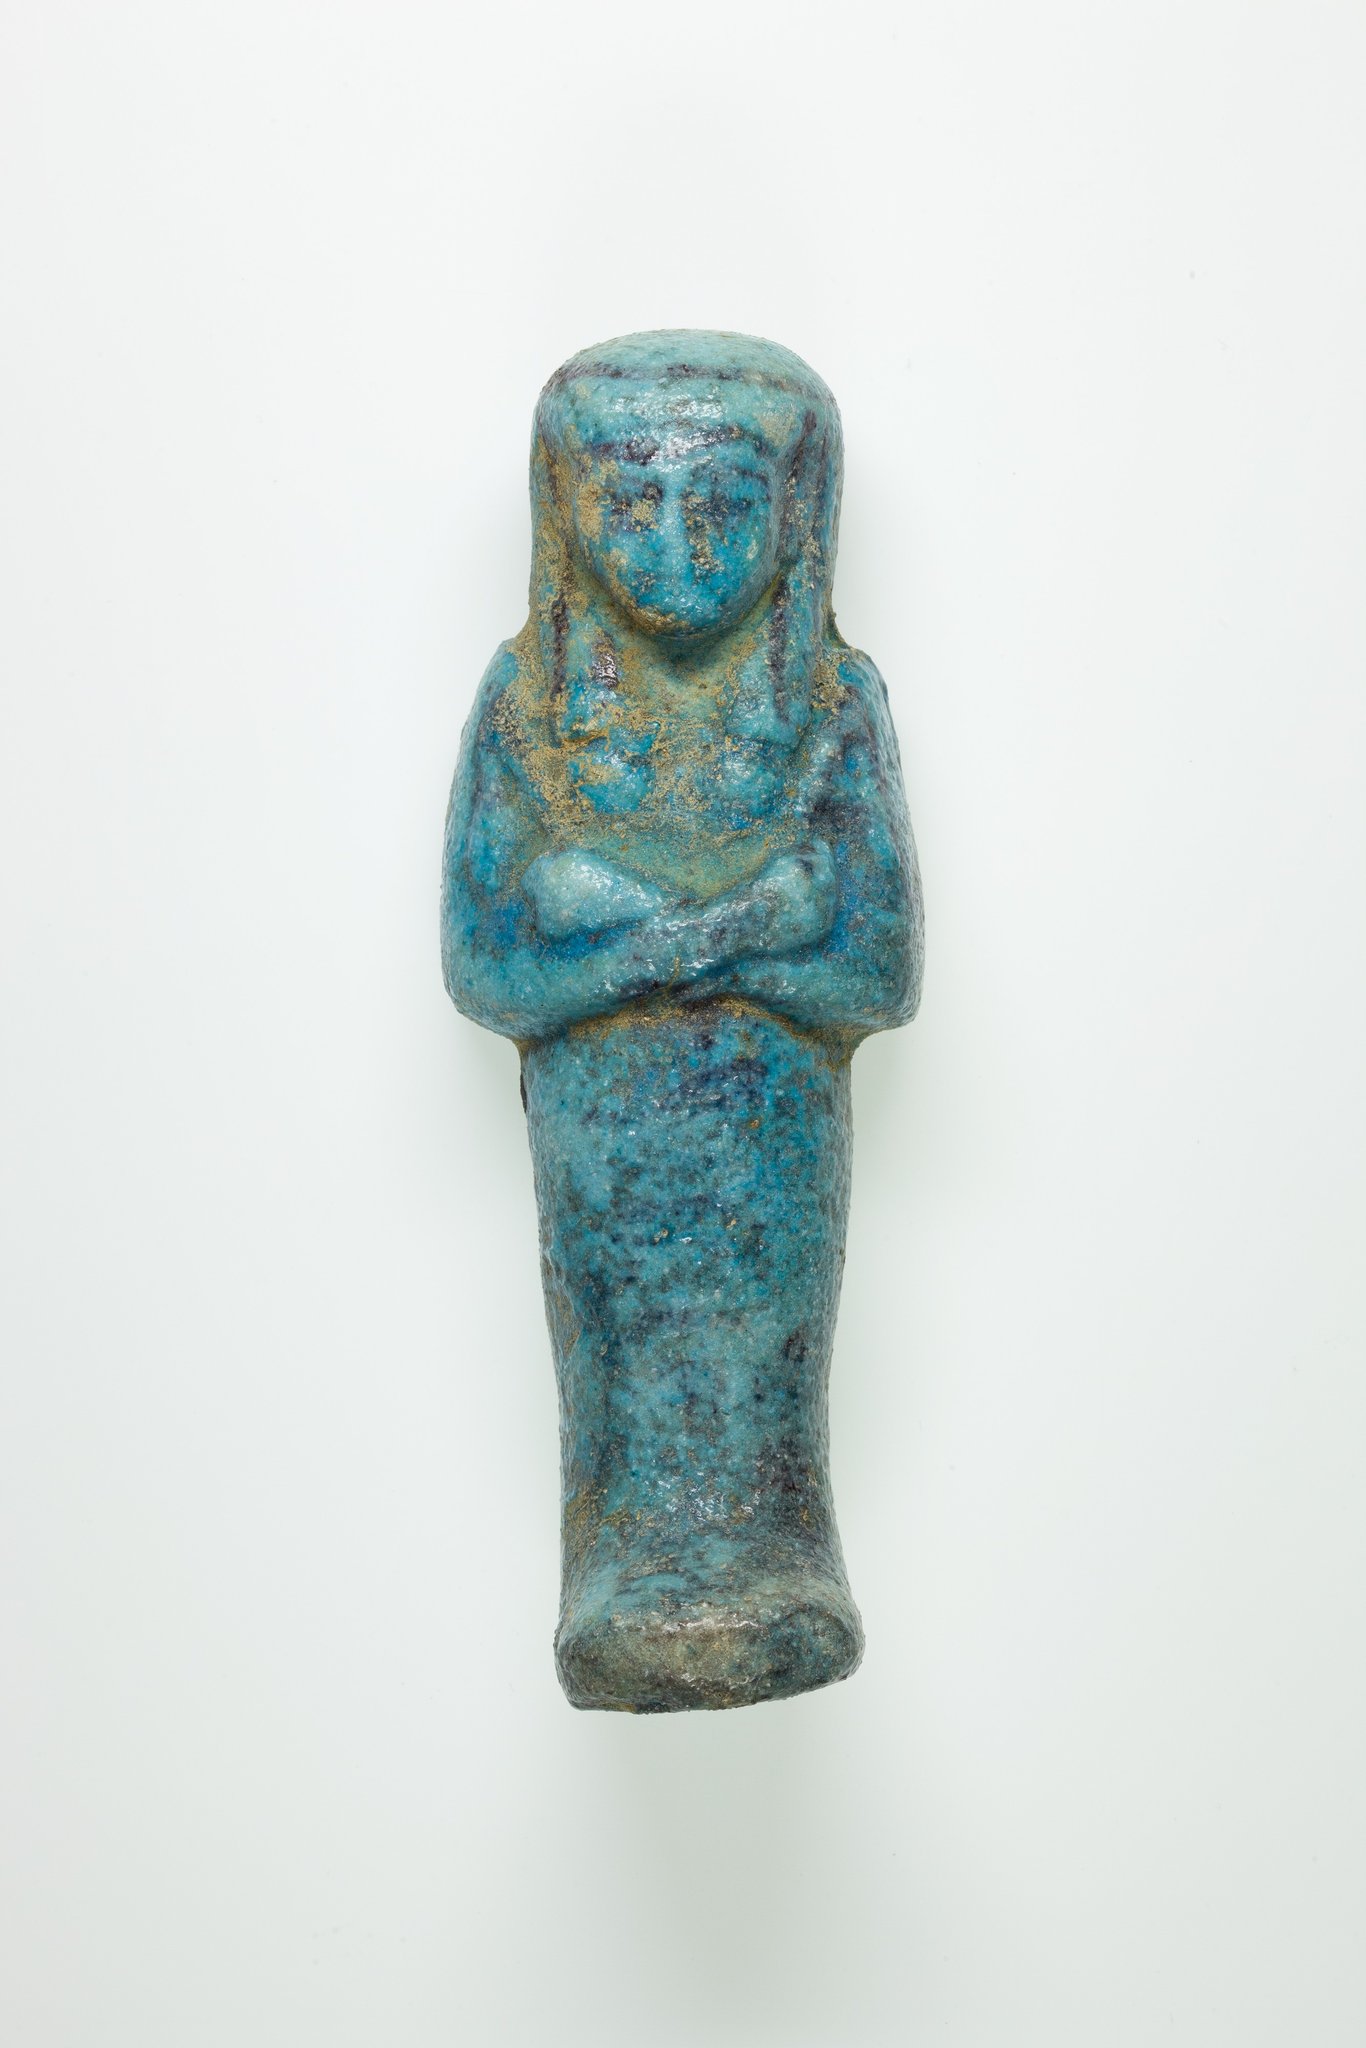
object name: worker shabti, henettawy c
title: Worker Shabti of Henettawy (C), Daughter of Isetemkheb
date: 990-970 BCE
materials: faience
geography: egypt